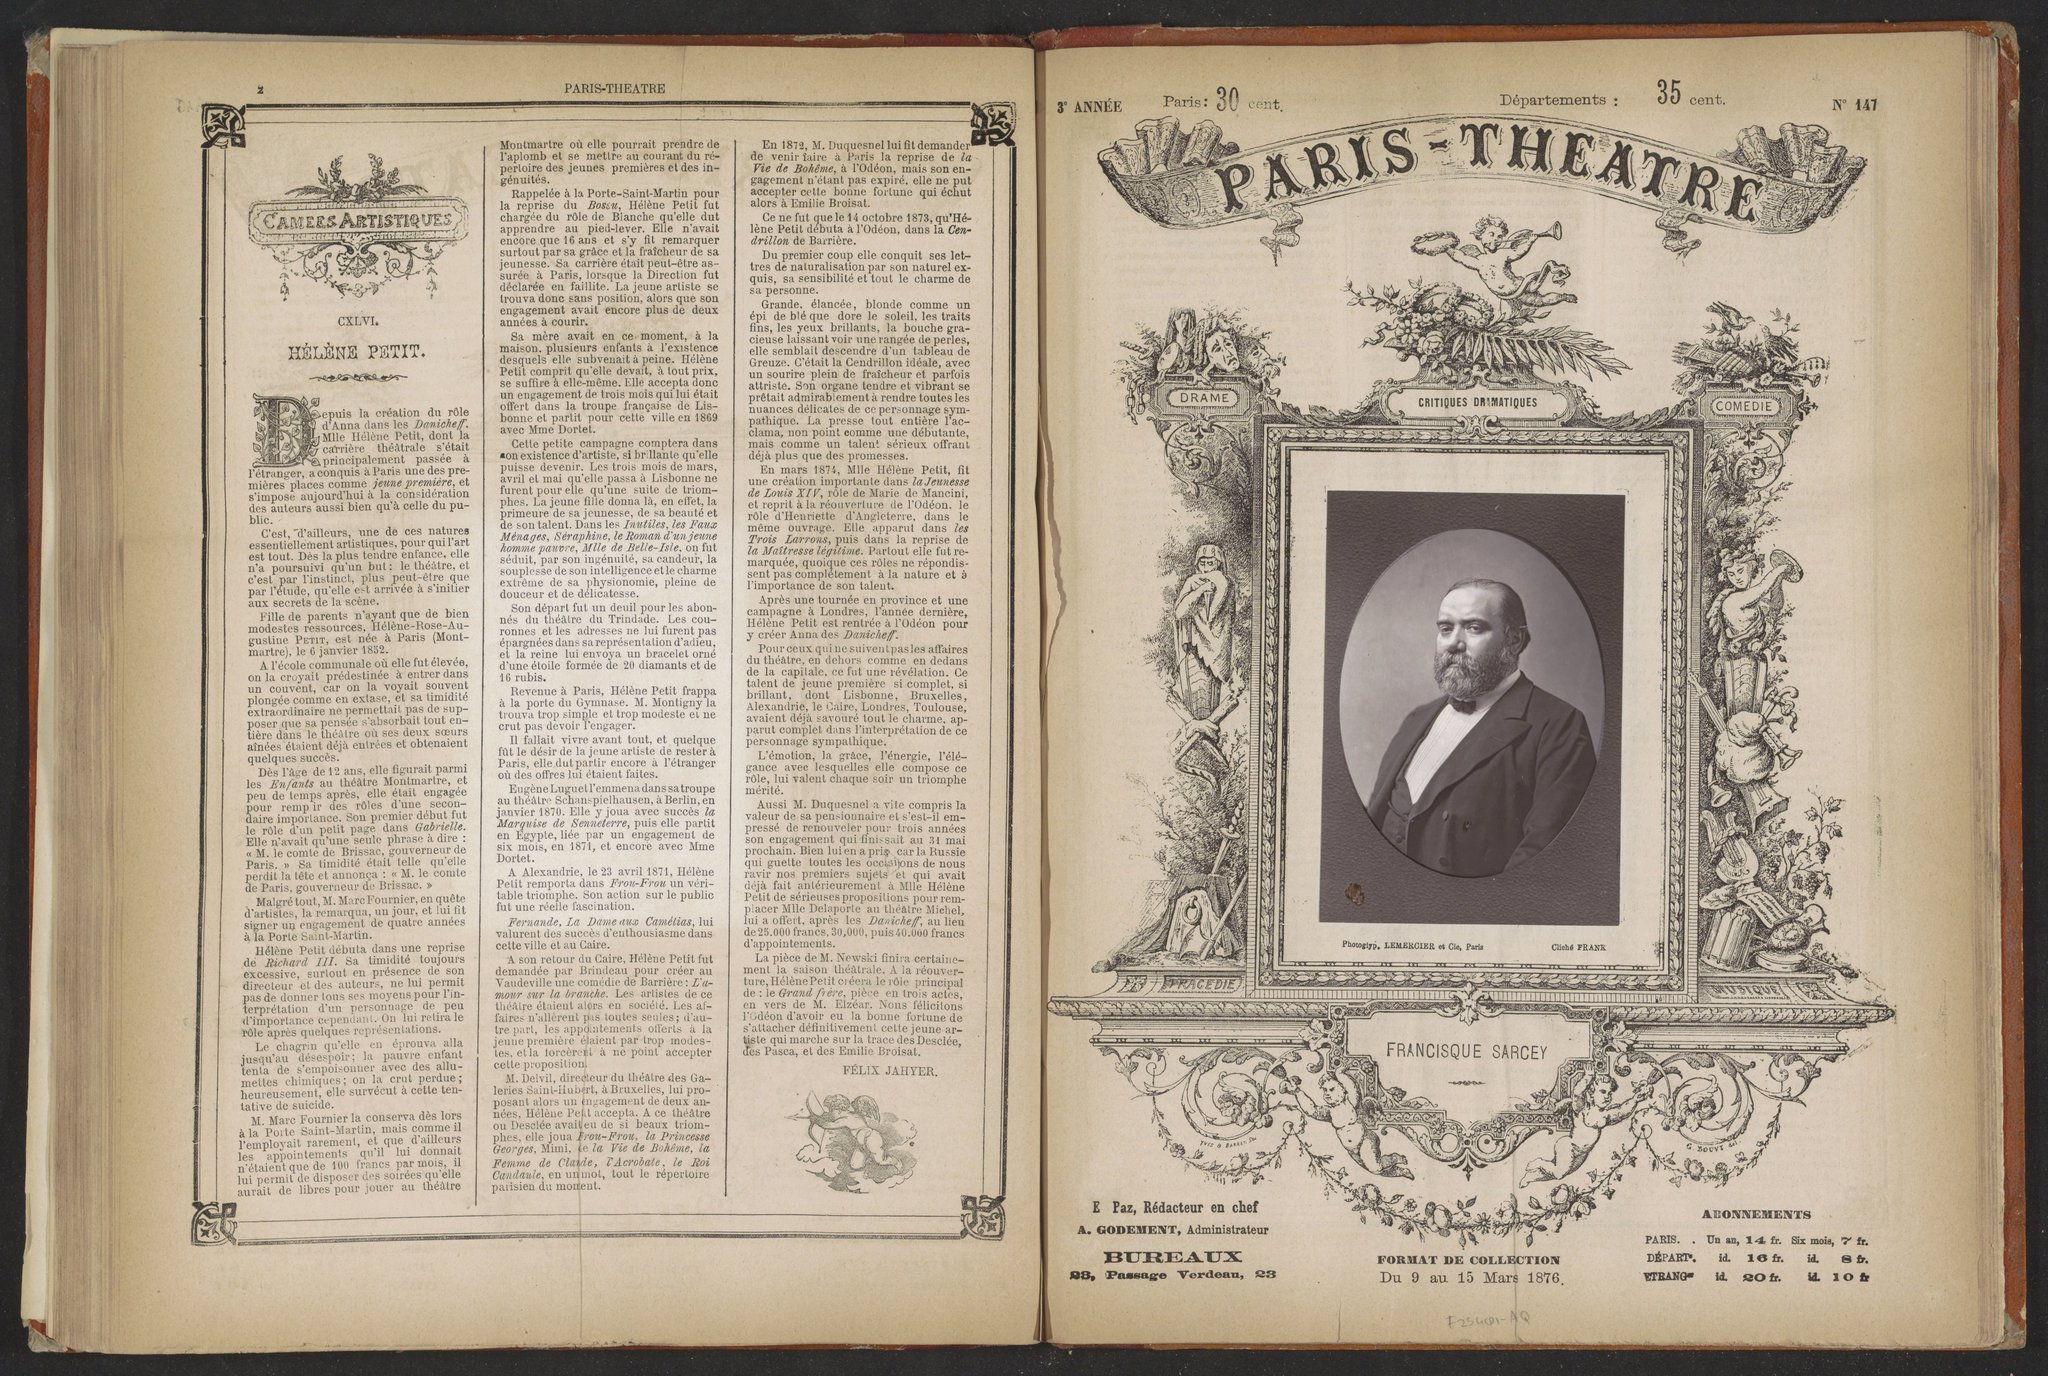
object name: page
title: Portret van Francisque Sarcey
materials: paper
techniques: woodburytype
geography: paris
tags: journalist, reporter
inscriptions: inscription: ‘Du 9 au 15 Mars 1976.’, number: ‘No 147’